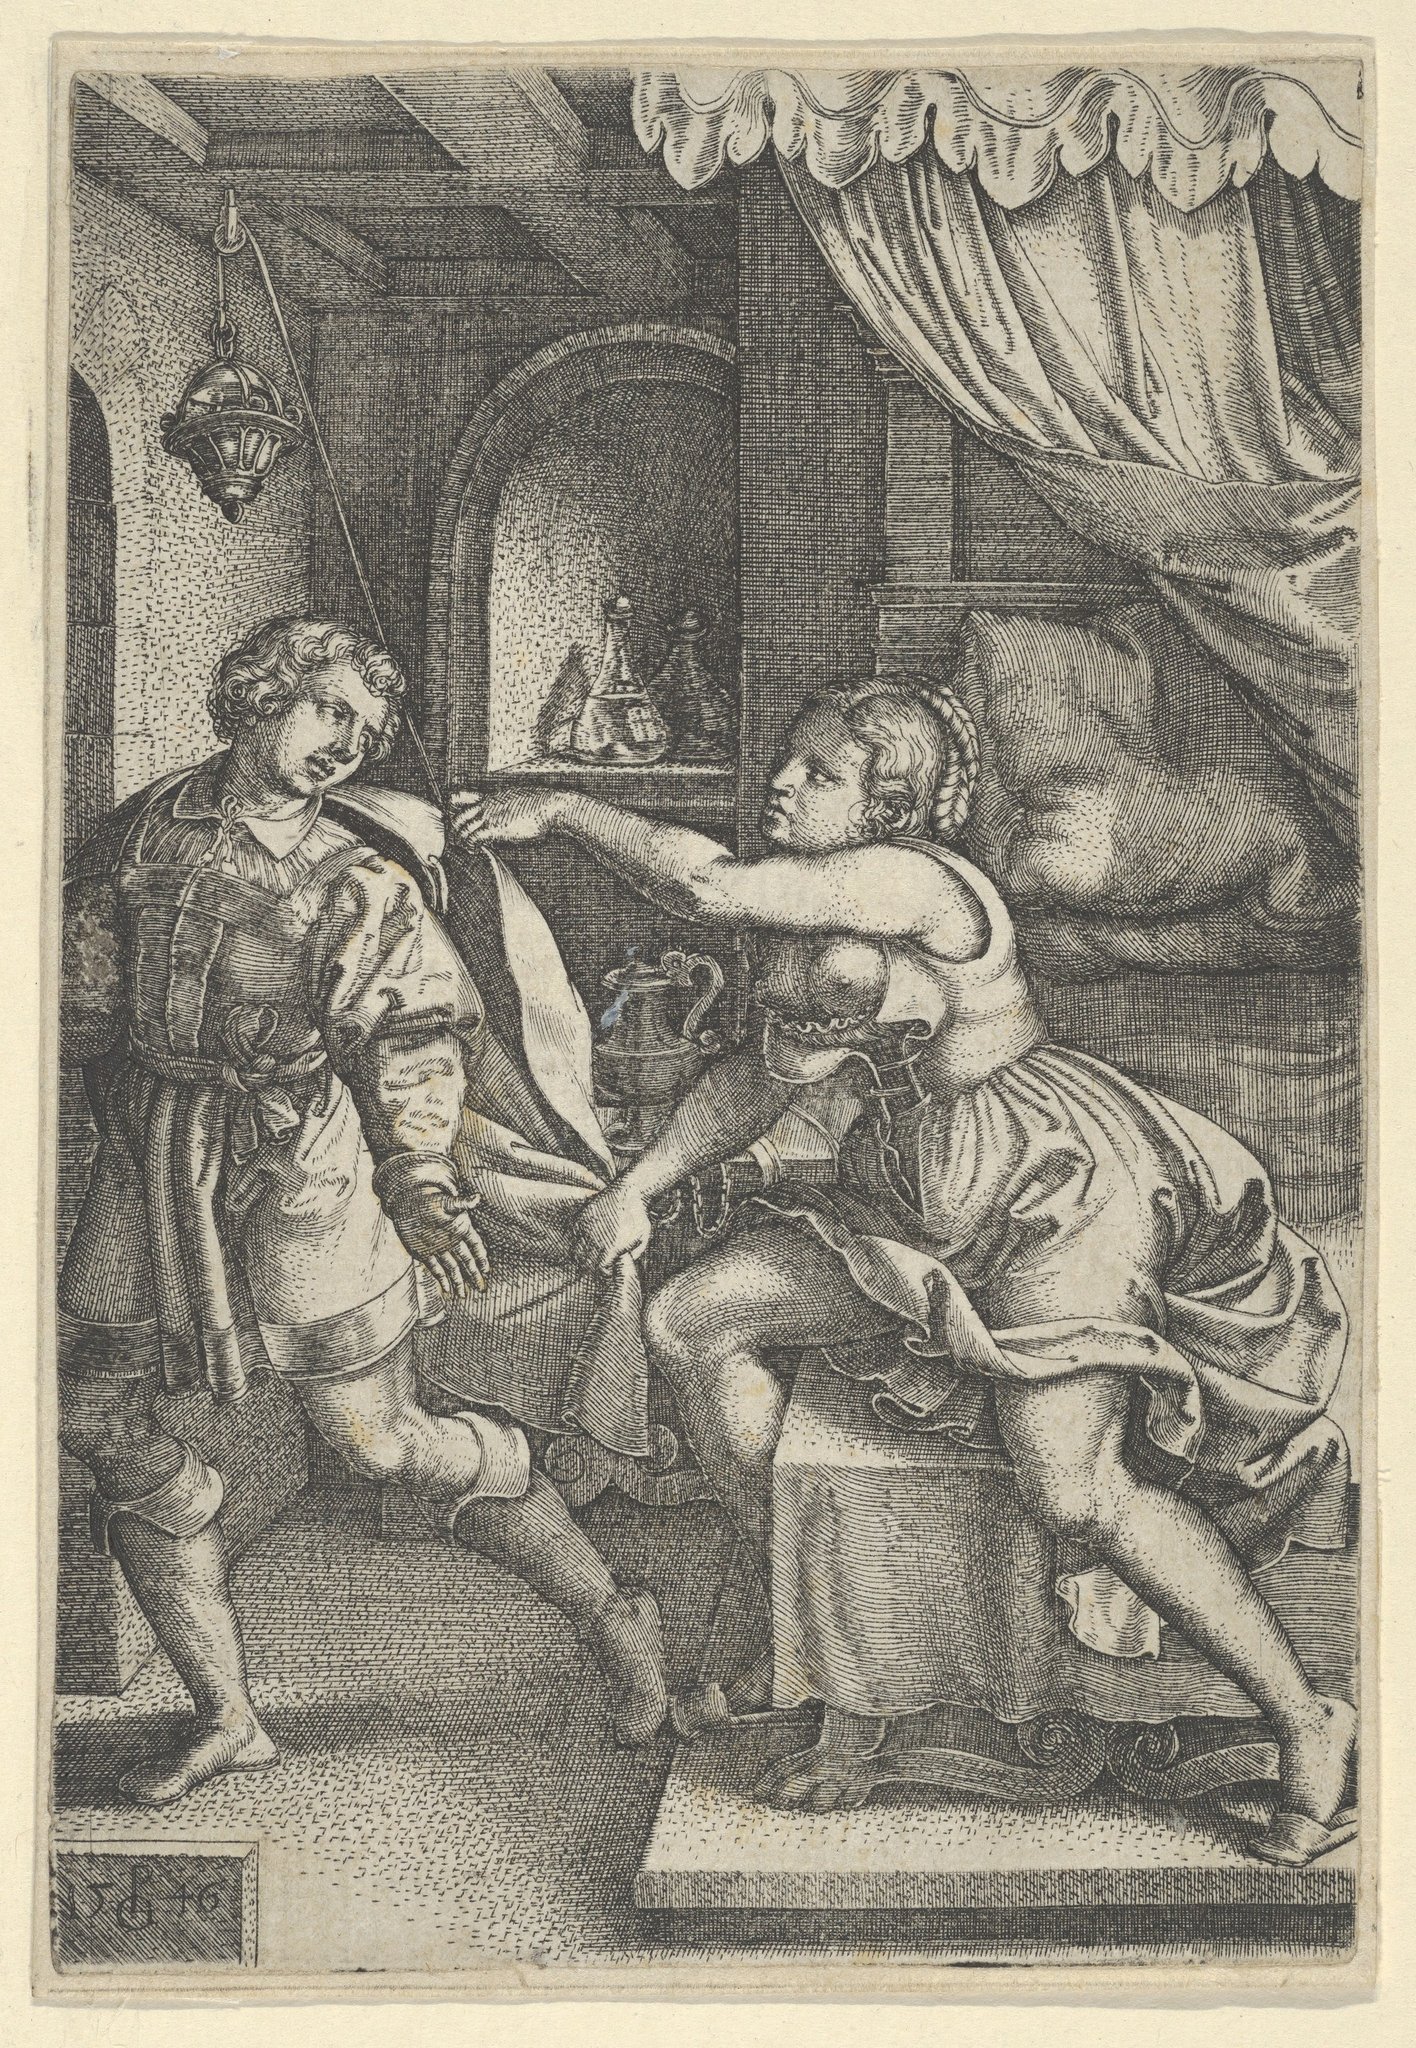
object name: print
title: Joseph and Potiphar's Wife, from "The Story of Joseph"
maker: georg pencz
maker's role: artist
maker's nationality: german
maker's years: 1500-1550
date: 1546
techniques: engraving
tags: men,female nudes